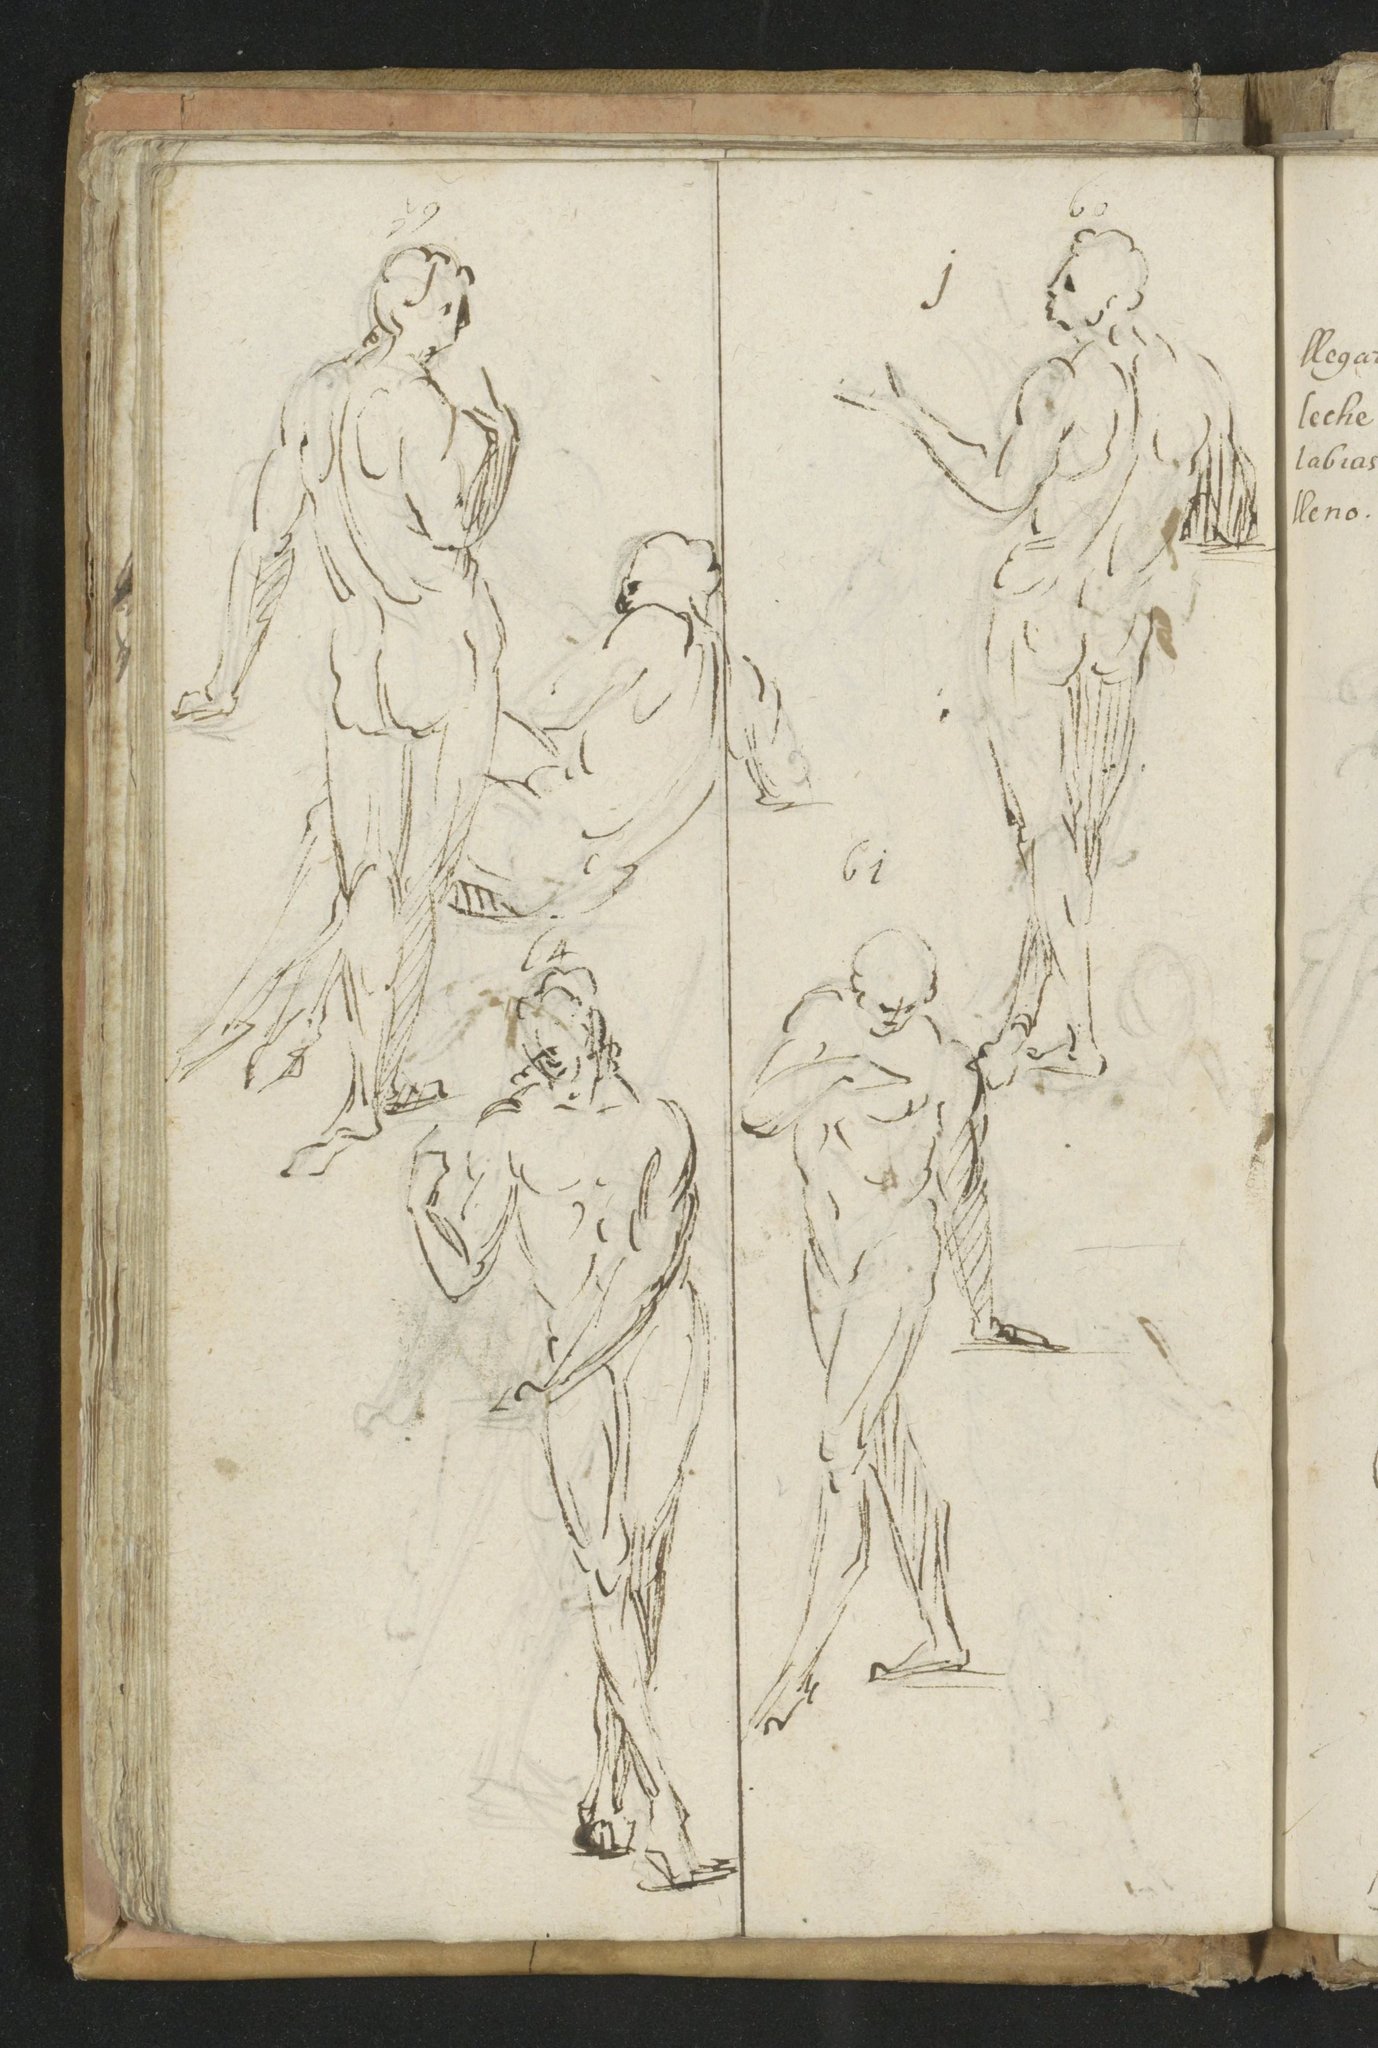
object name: sketchbook leaf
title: Naakte mannen in verschillende sta- en zithoudingen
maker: Anonymous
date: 1658-1728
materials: ink, paper, pencil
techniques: pen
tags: standing figure, sitting figure, the (nude) human figure; 'corpo humano' (ripa)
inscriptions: annotation: ‘j j’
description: Blad 22 verso uit een schetsboek met 33 bladen.